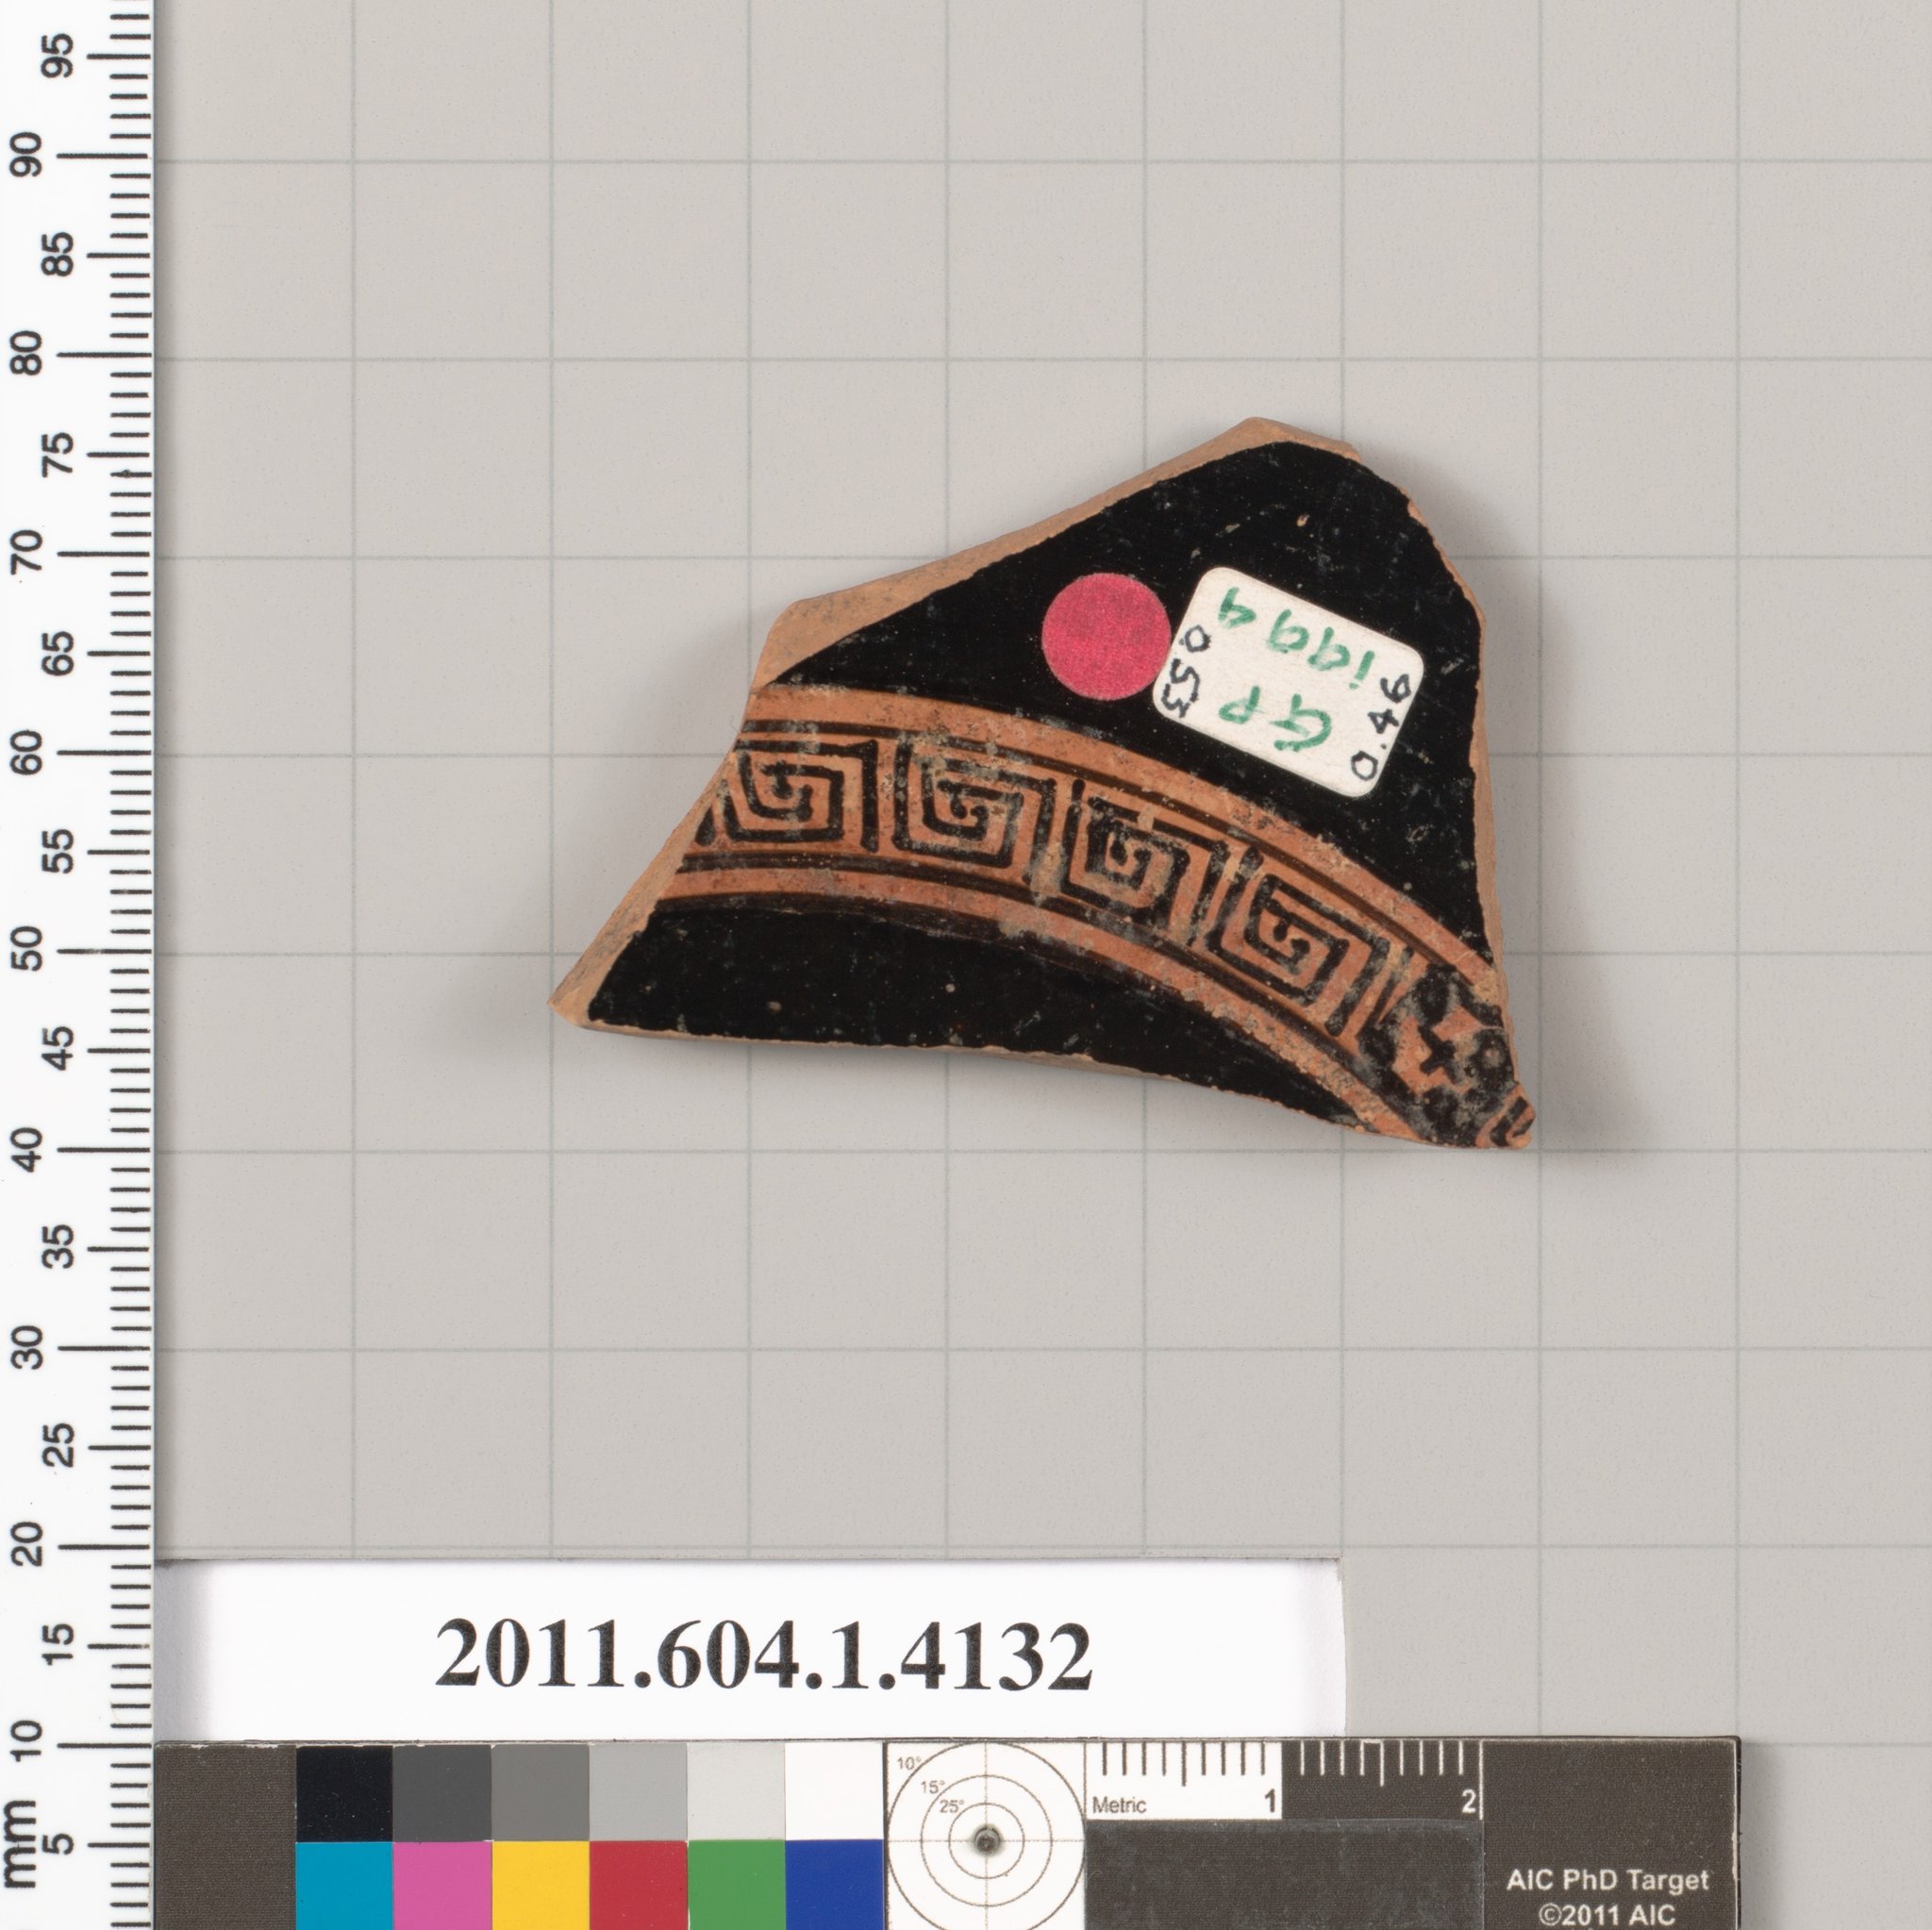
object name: kylix fragment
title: Terracotta fragment of a kylix (drinking cup)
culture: greek, attic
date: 490-470 BCE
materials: terracotta